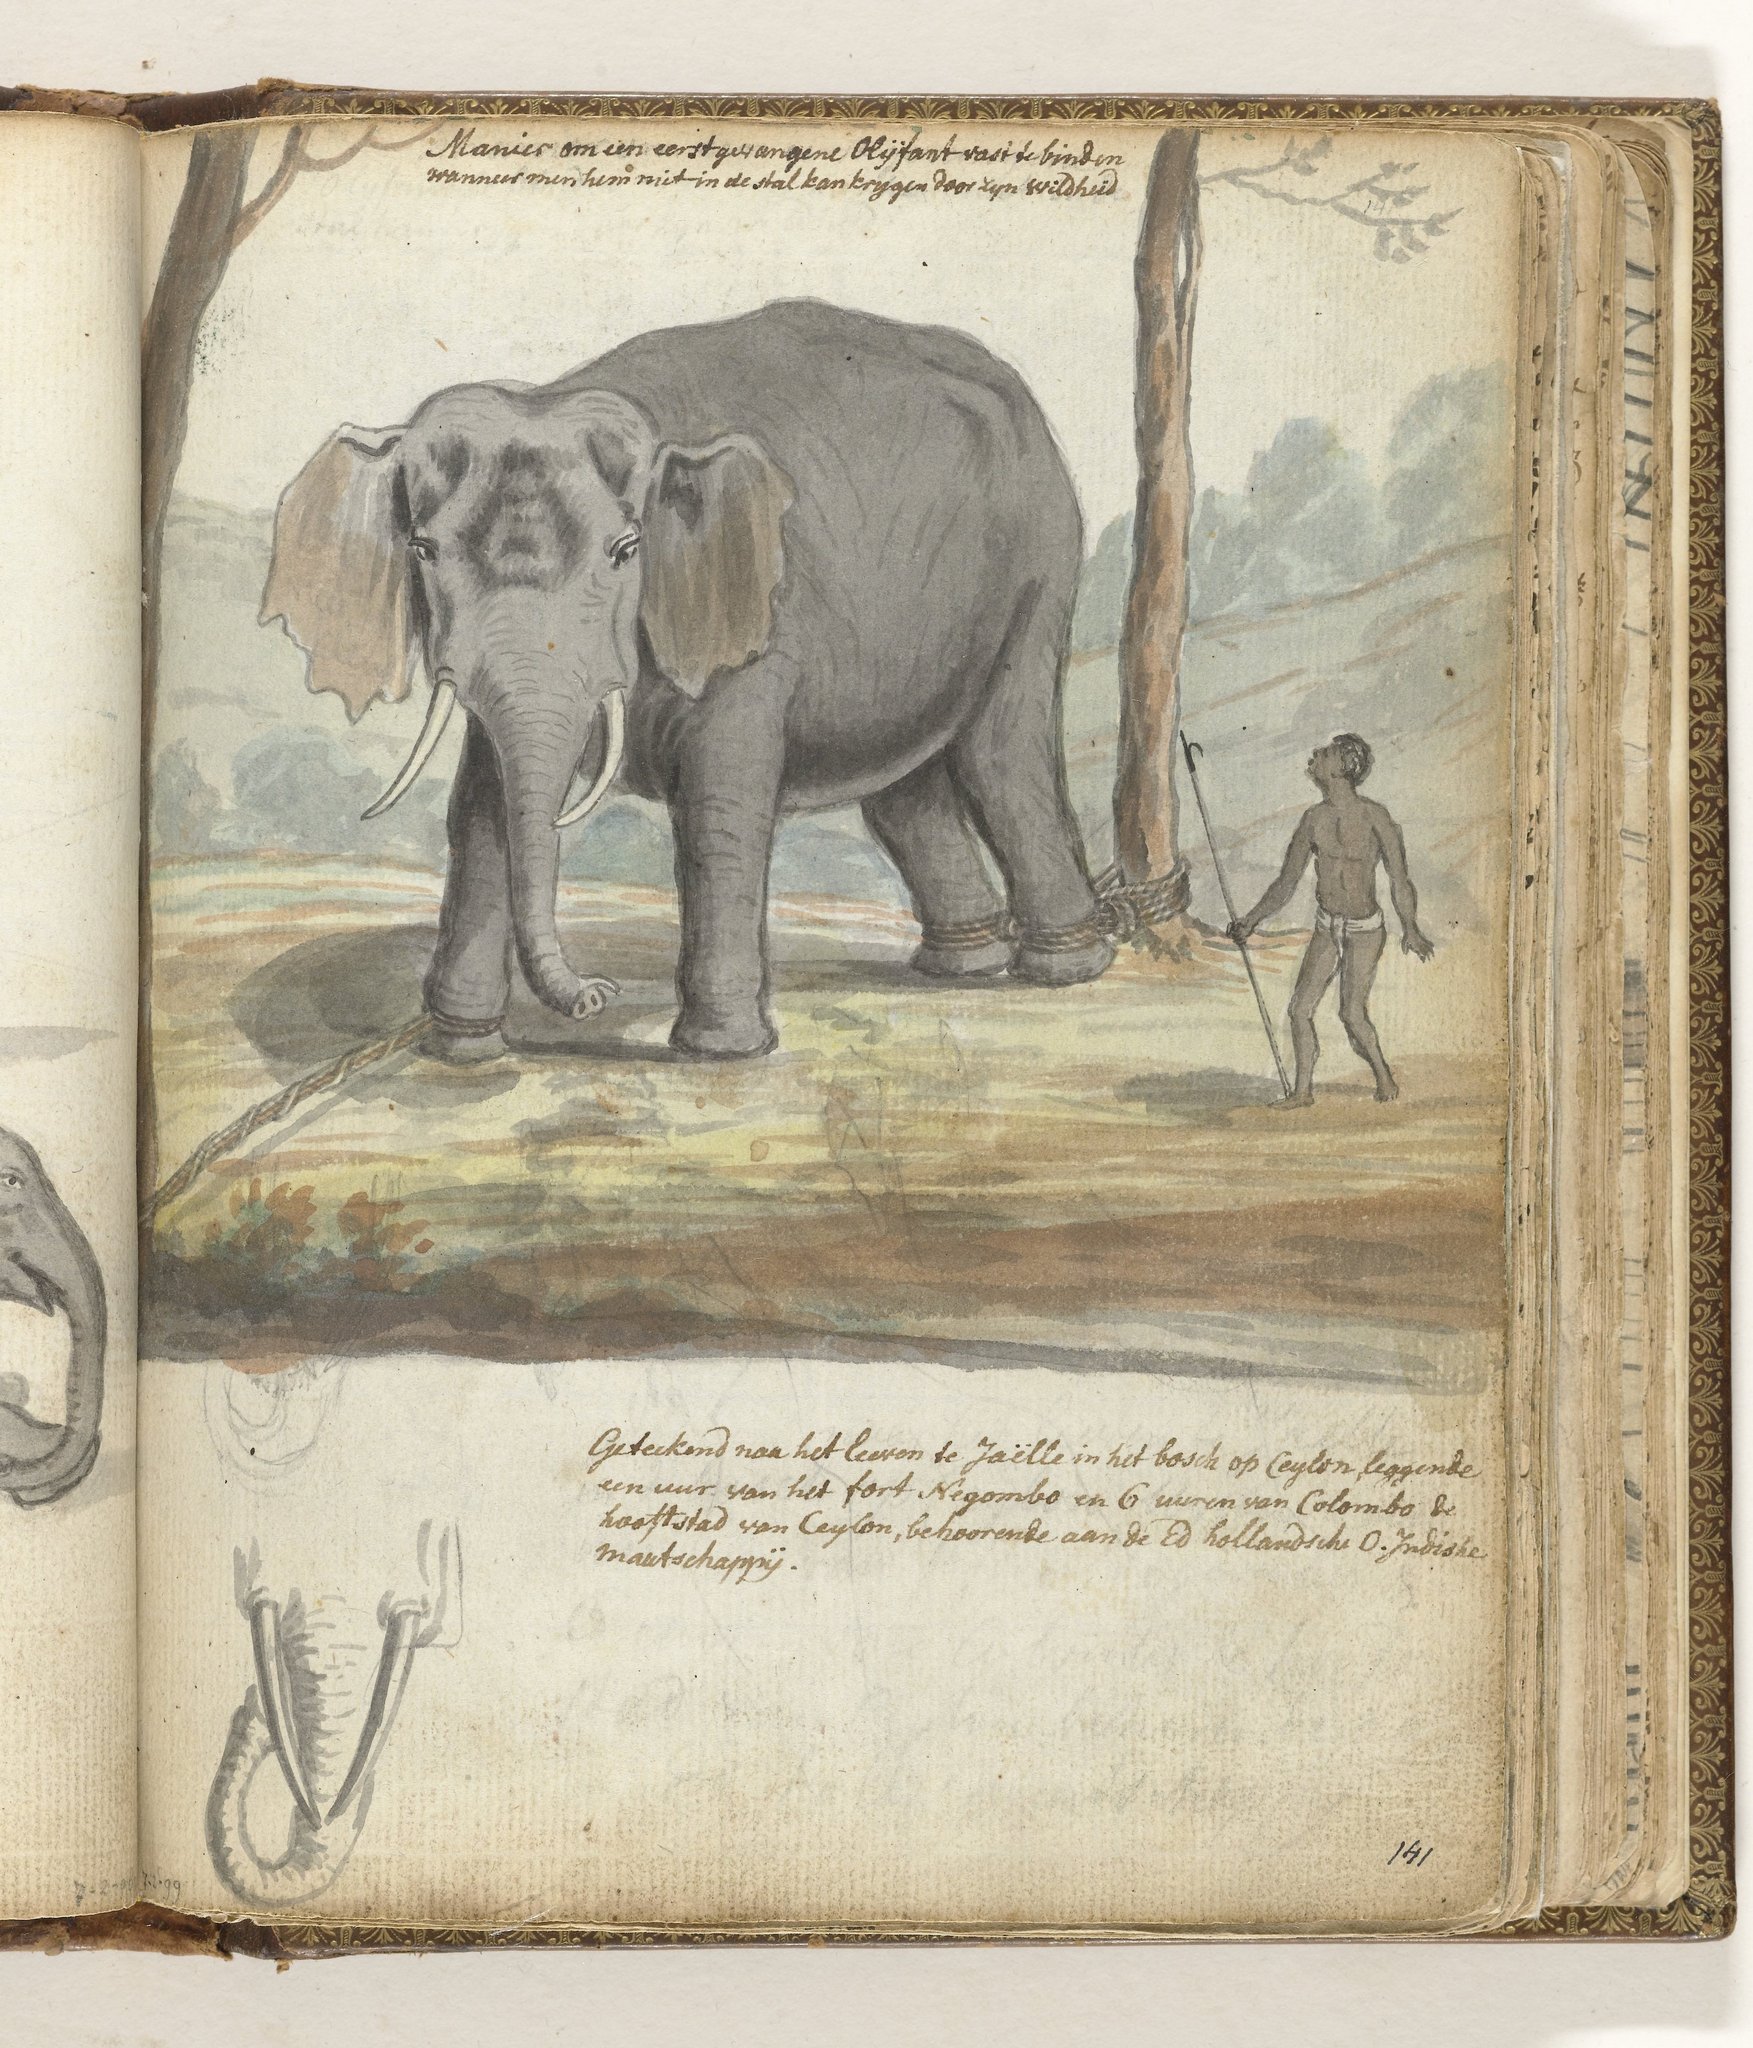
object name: drawing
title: Wilde olifant tussen bomen gebonden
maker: jan brandes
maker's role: draughtsman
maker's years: 1743-1808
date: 1712-1785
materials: paper, pencil, watercolor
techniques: brush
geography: ja-ela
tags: trunked animals: elephant, sri lanka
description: Kleurtekening van een olifant aan zijn poten tussen twee bomen gebonden en een Singalees met piek. Slurf en slagtanden. Met opschrift. Onderdeel uit het schetsboek van Jan Brandes, dl. 2 (1808), p. 141.